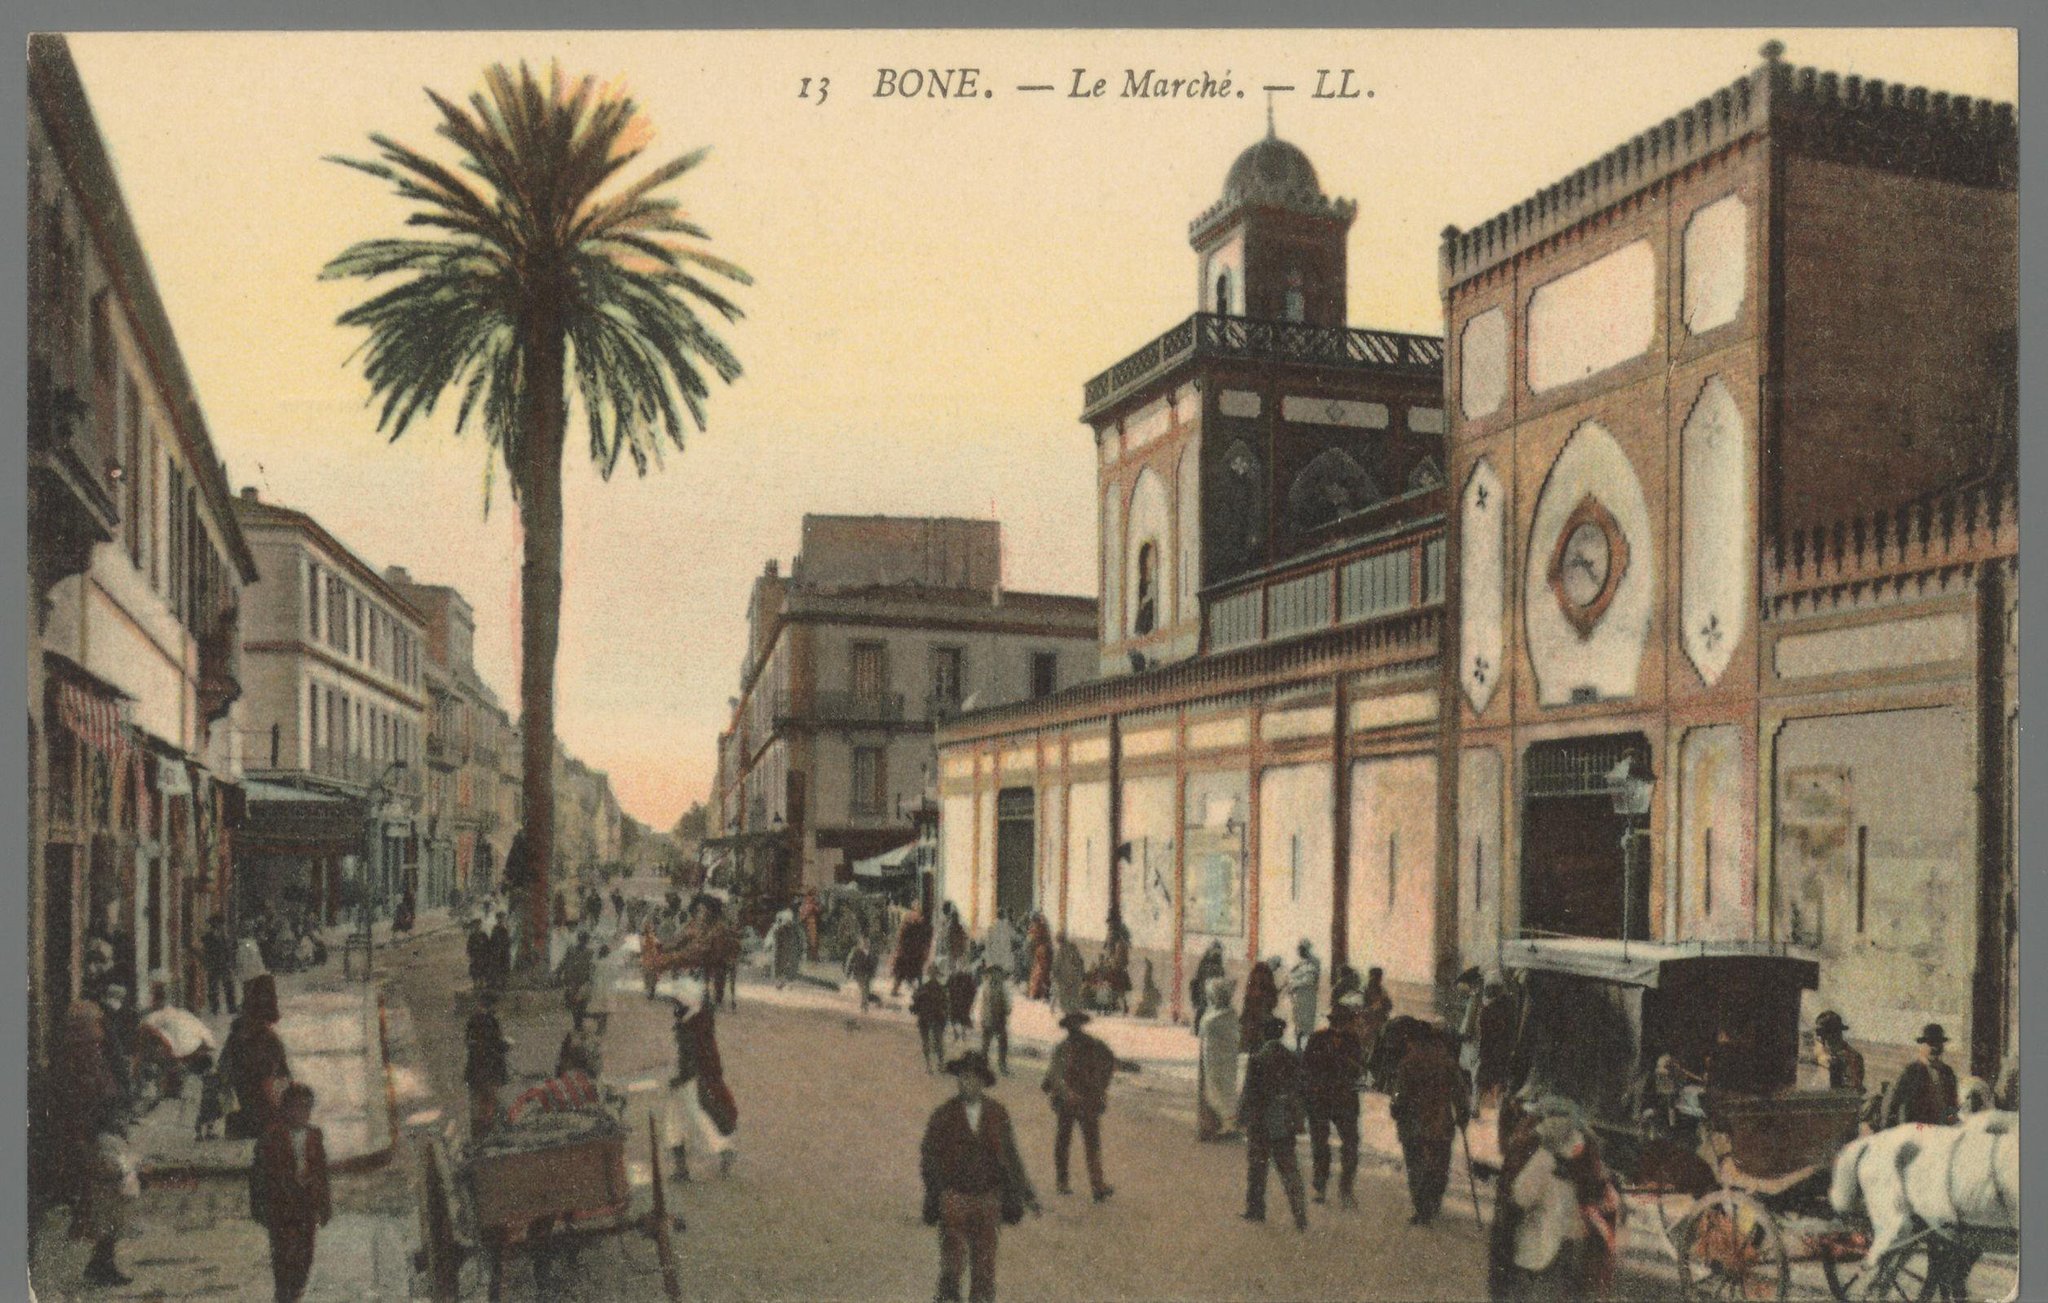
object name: ansichtkaart, prentbriefkaart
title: Bone. Le Marché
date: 1903-1905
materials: cardboard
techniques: photograph, lithograph, writing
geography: bône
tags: market-hall, street (+ city(-scape) with figures, staffage)